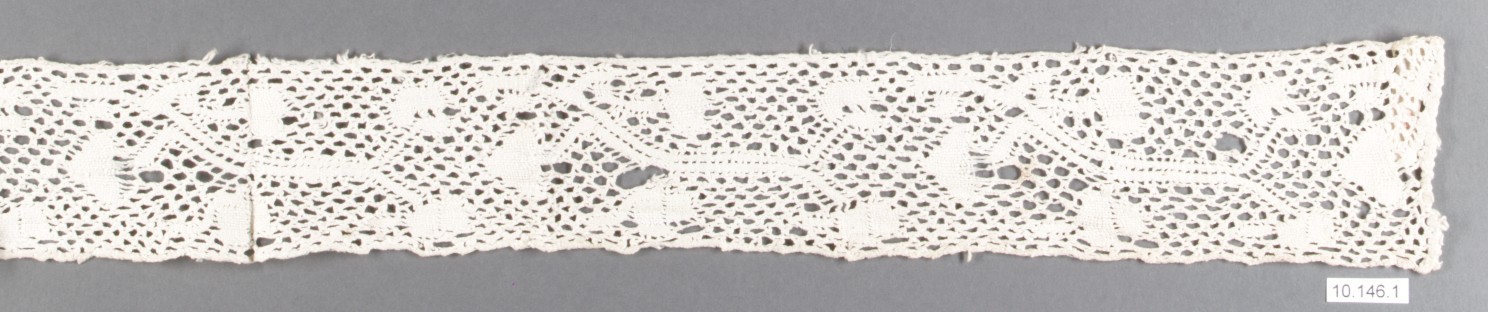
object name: strip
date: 1701-1800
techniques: lace